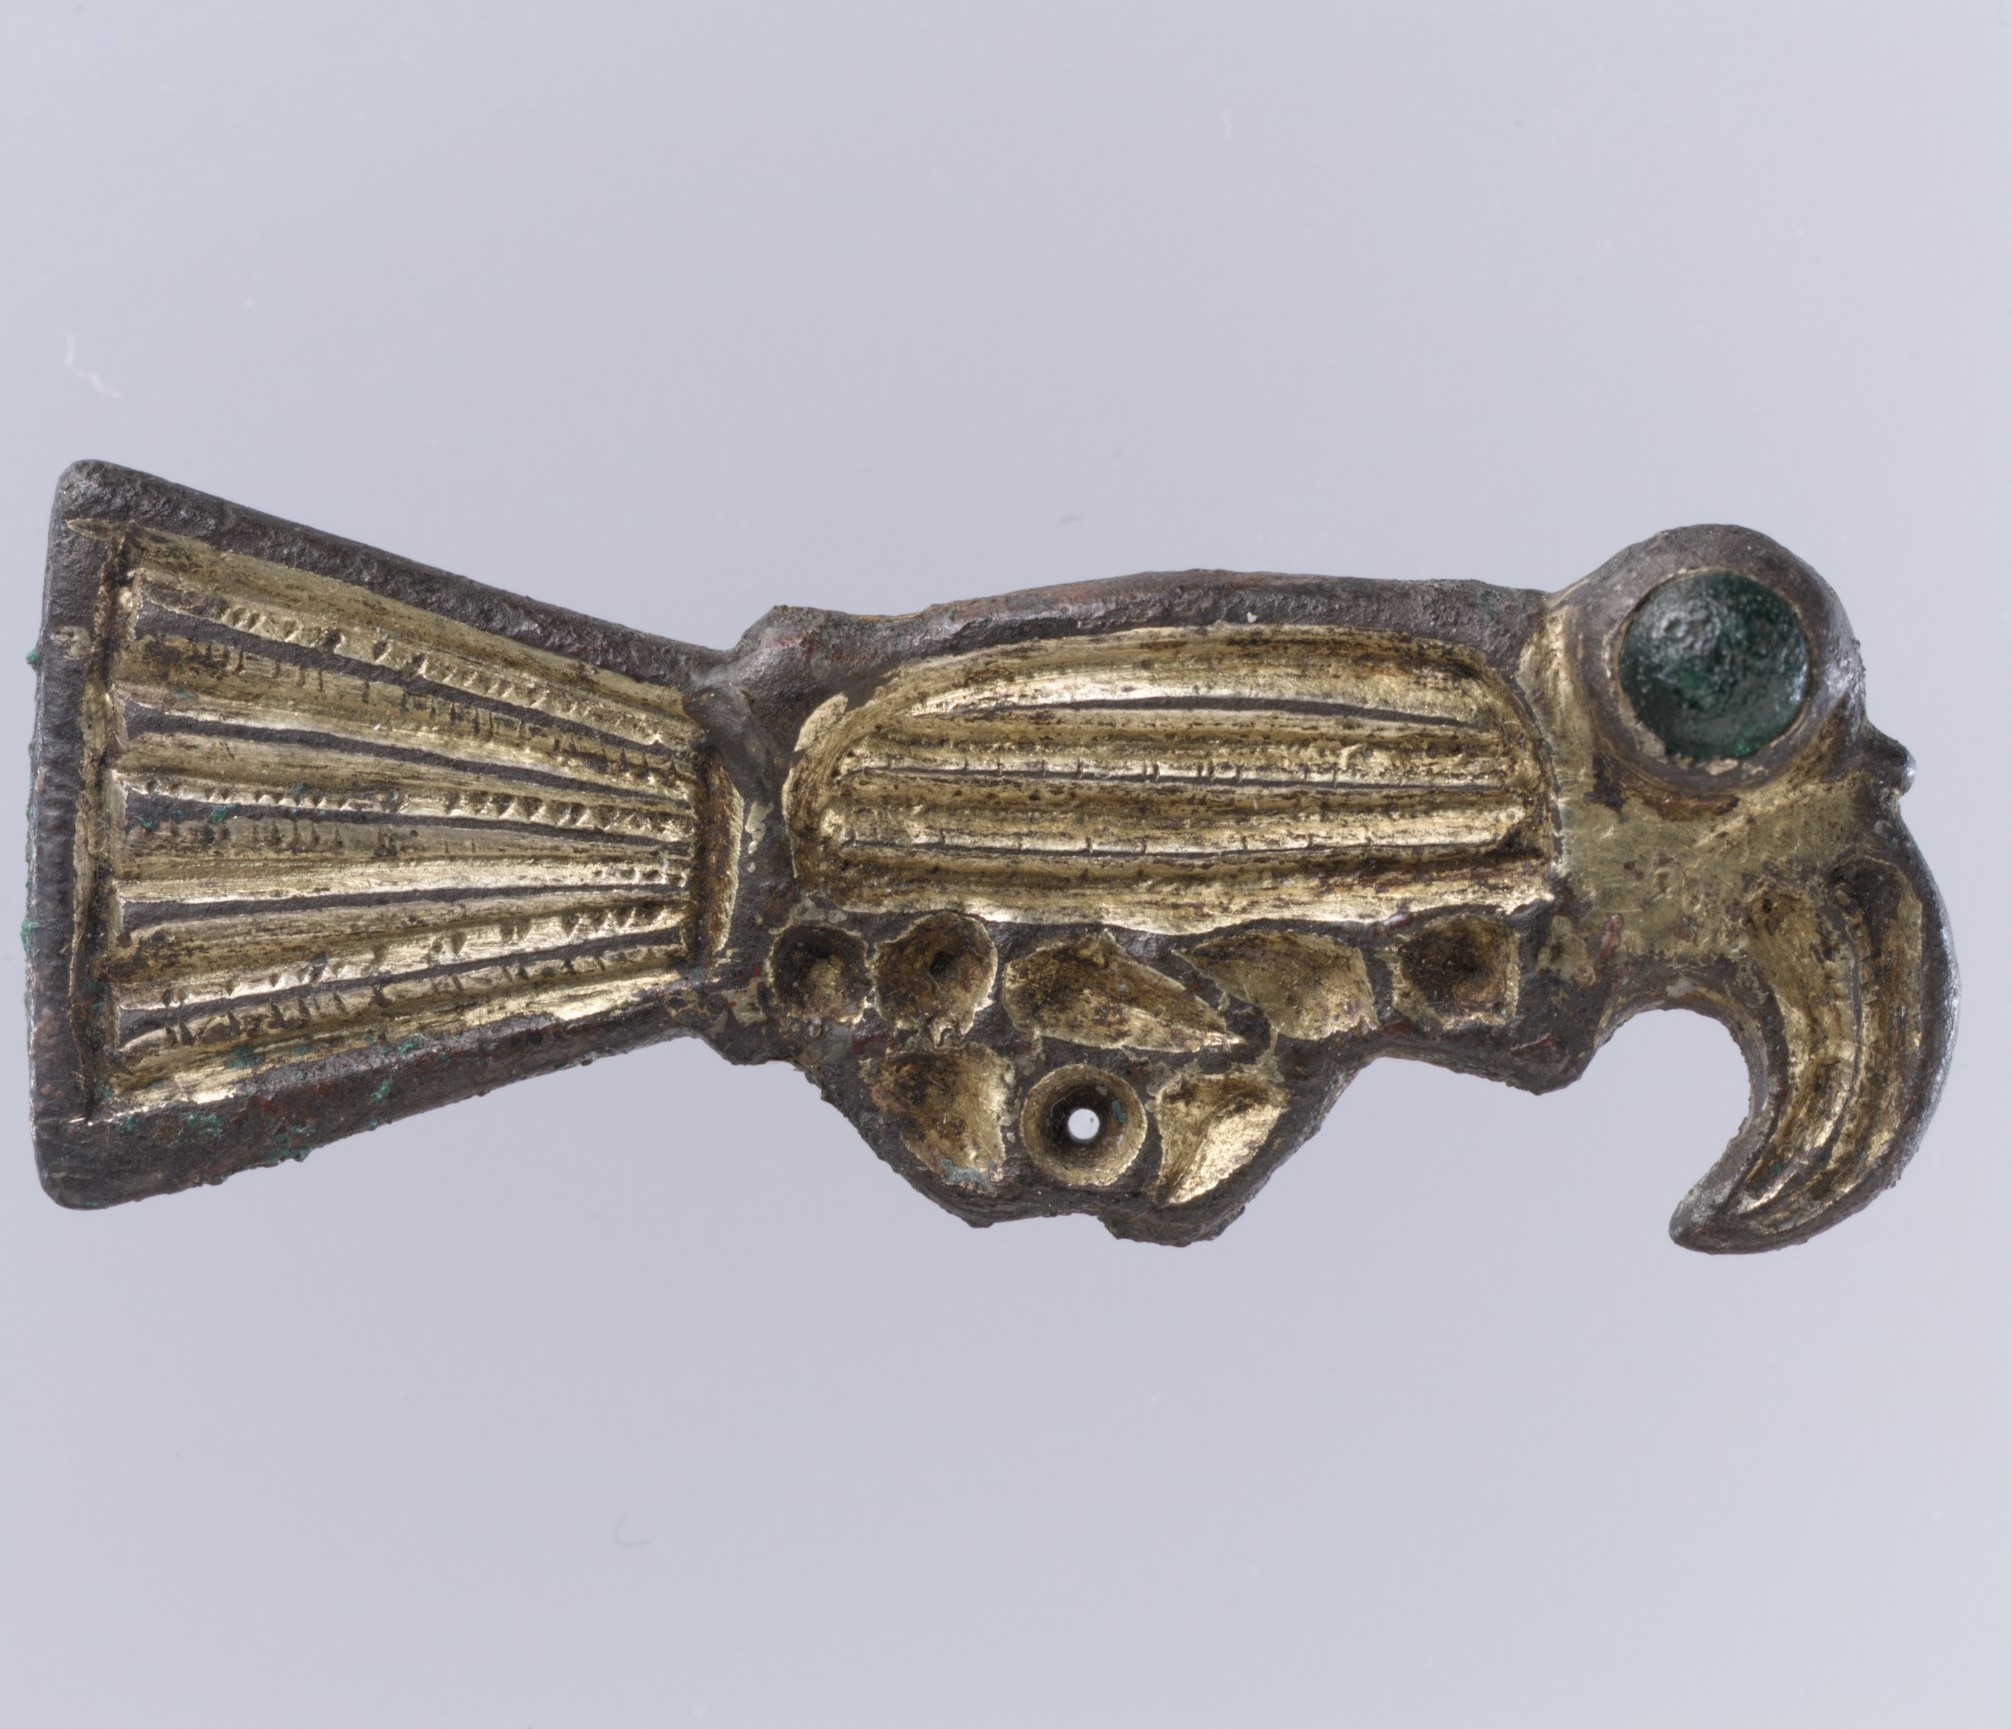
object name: brooch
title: Bird-Shaped Brooch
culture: frankish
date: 601-650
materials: glass, silver gilt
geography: northern france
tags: birds